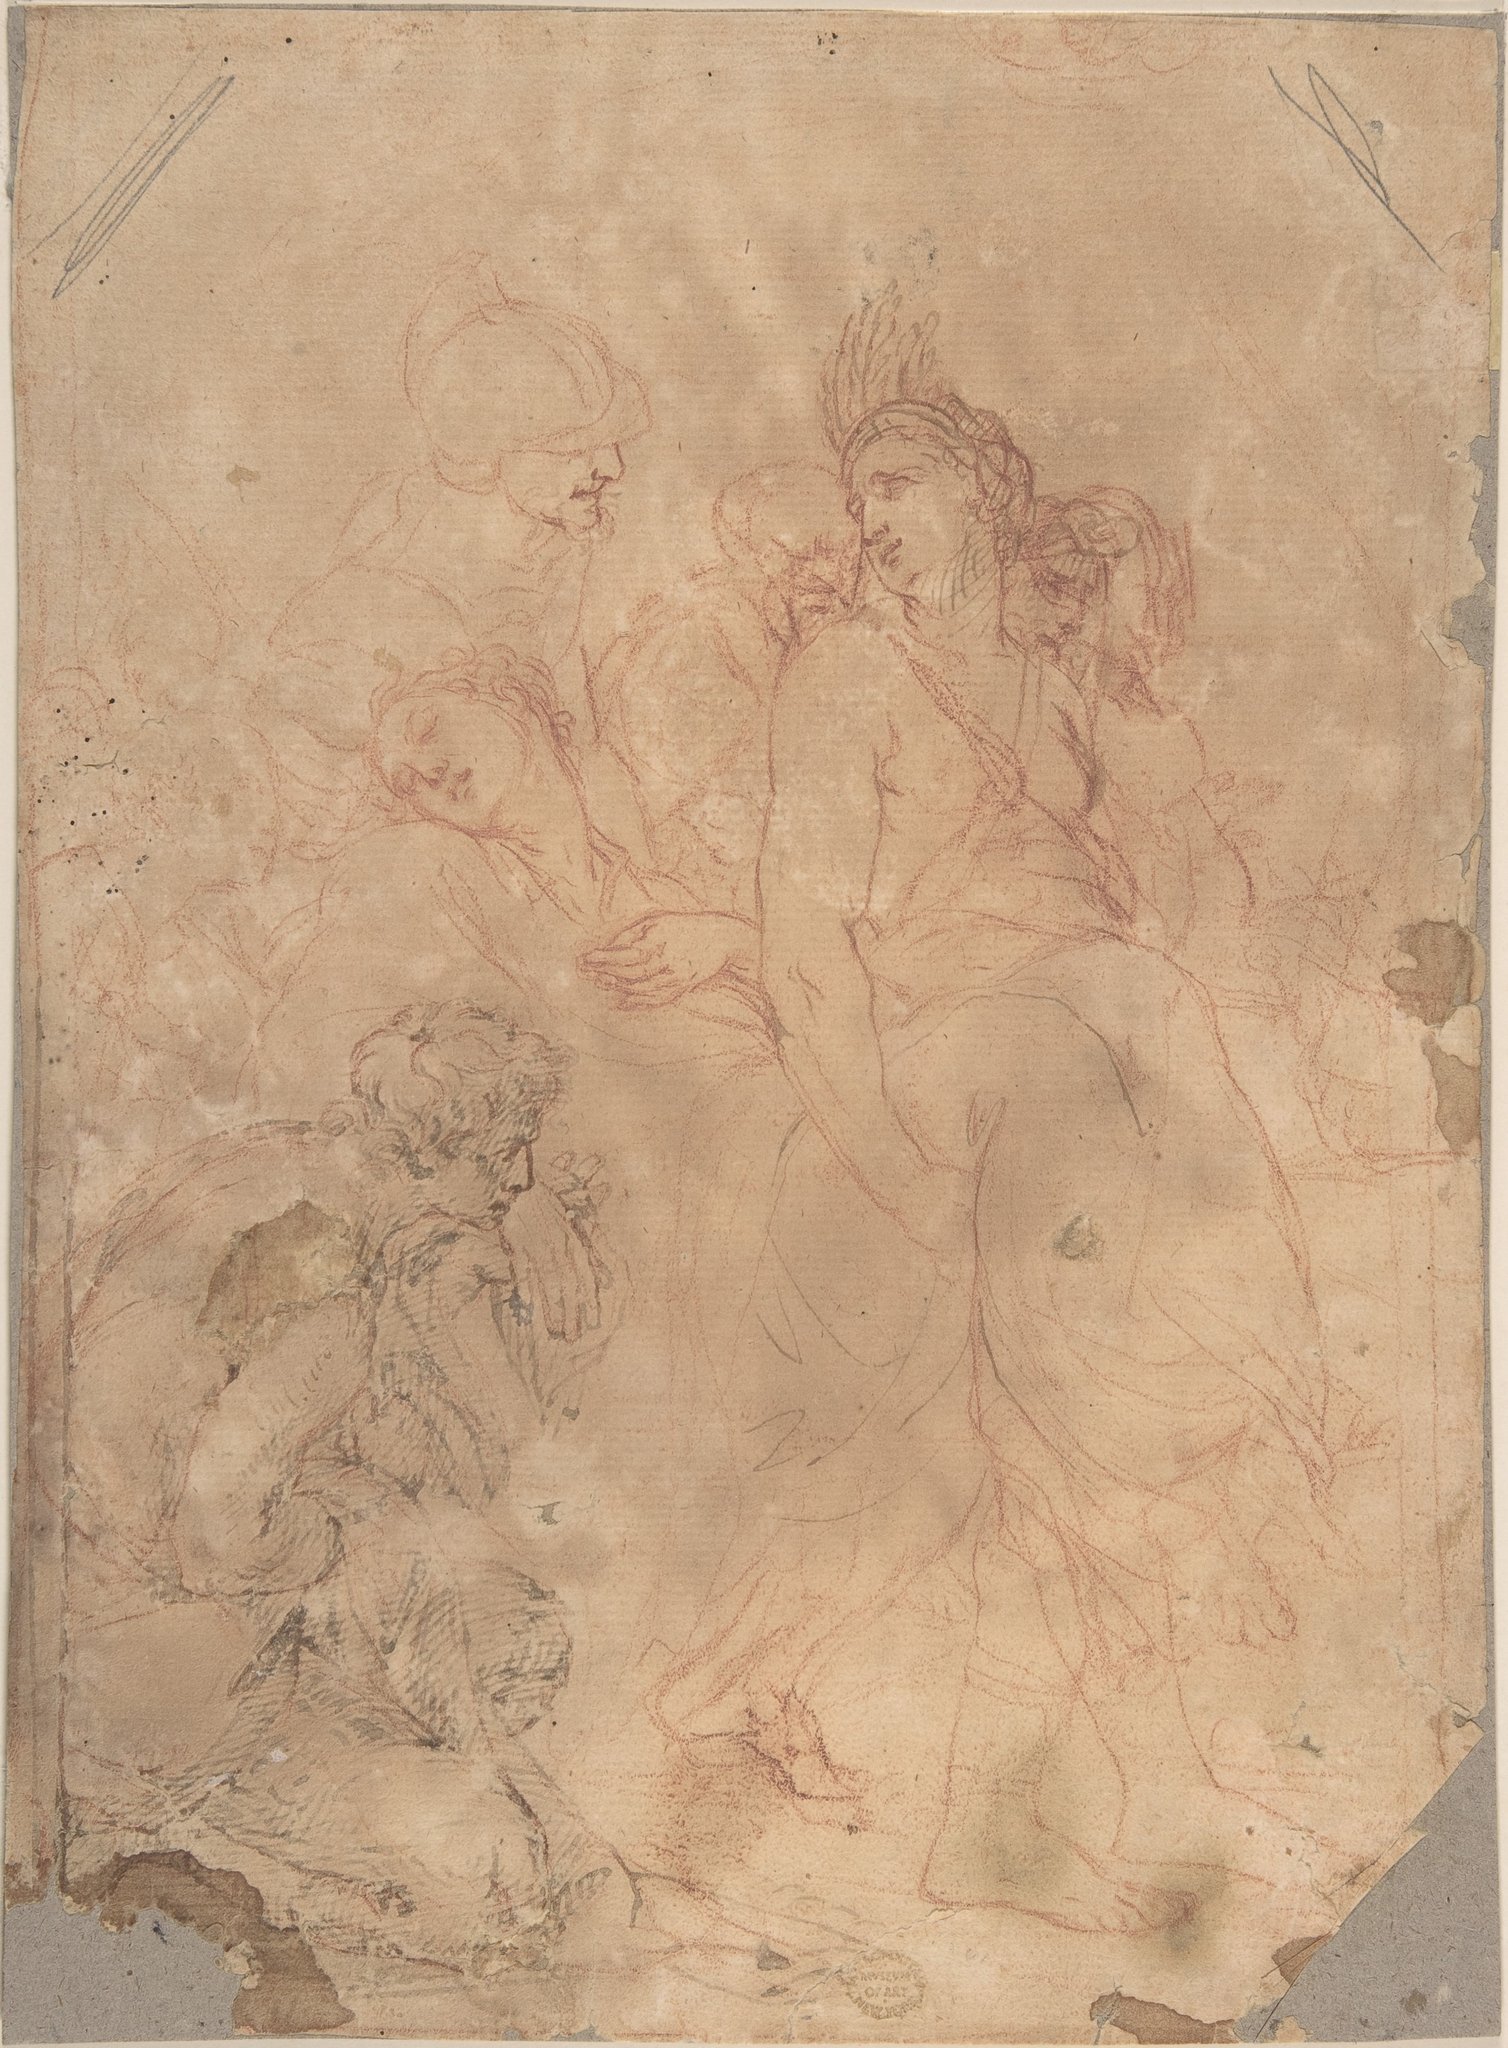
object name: drawing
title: Figures Carrying a Fainting (or Dead) Woman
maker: anonymous, italian, roman-bolognese, 17th century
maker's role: artist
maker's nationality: italian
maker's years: 1600-1700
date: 1601-1700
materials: chalk, ink, paper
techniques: pen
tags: suffering,men,women